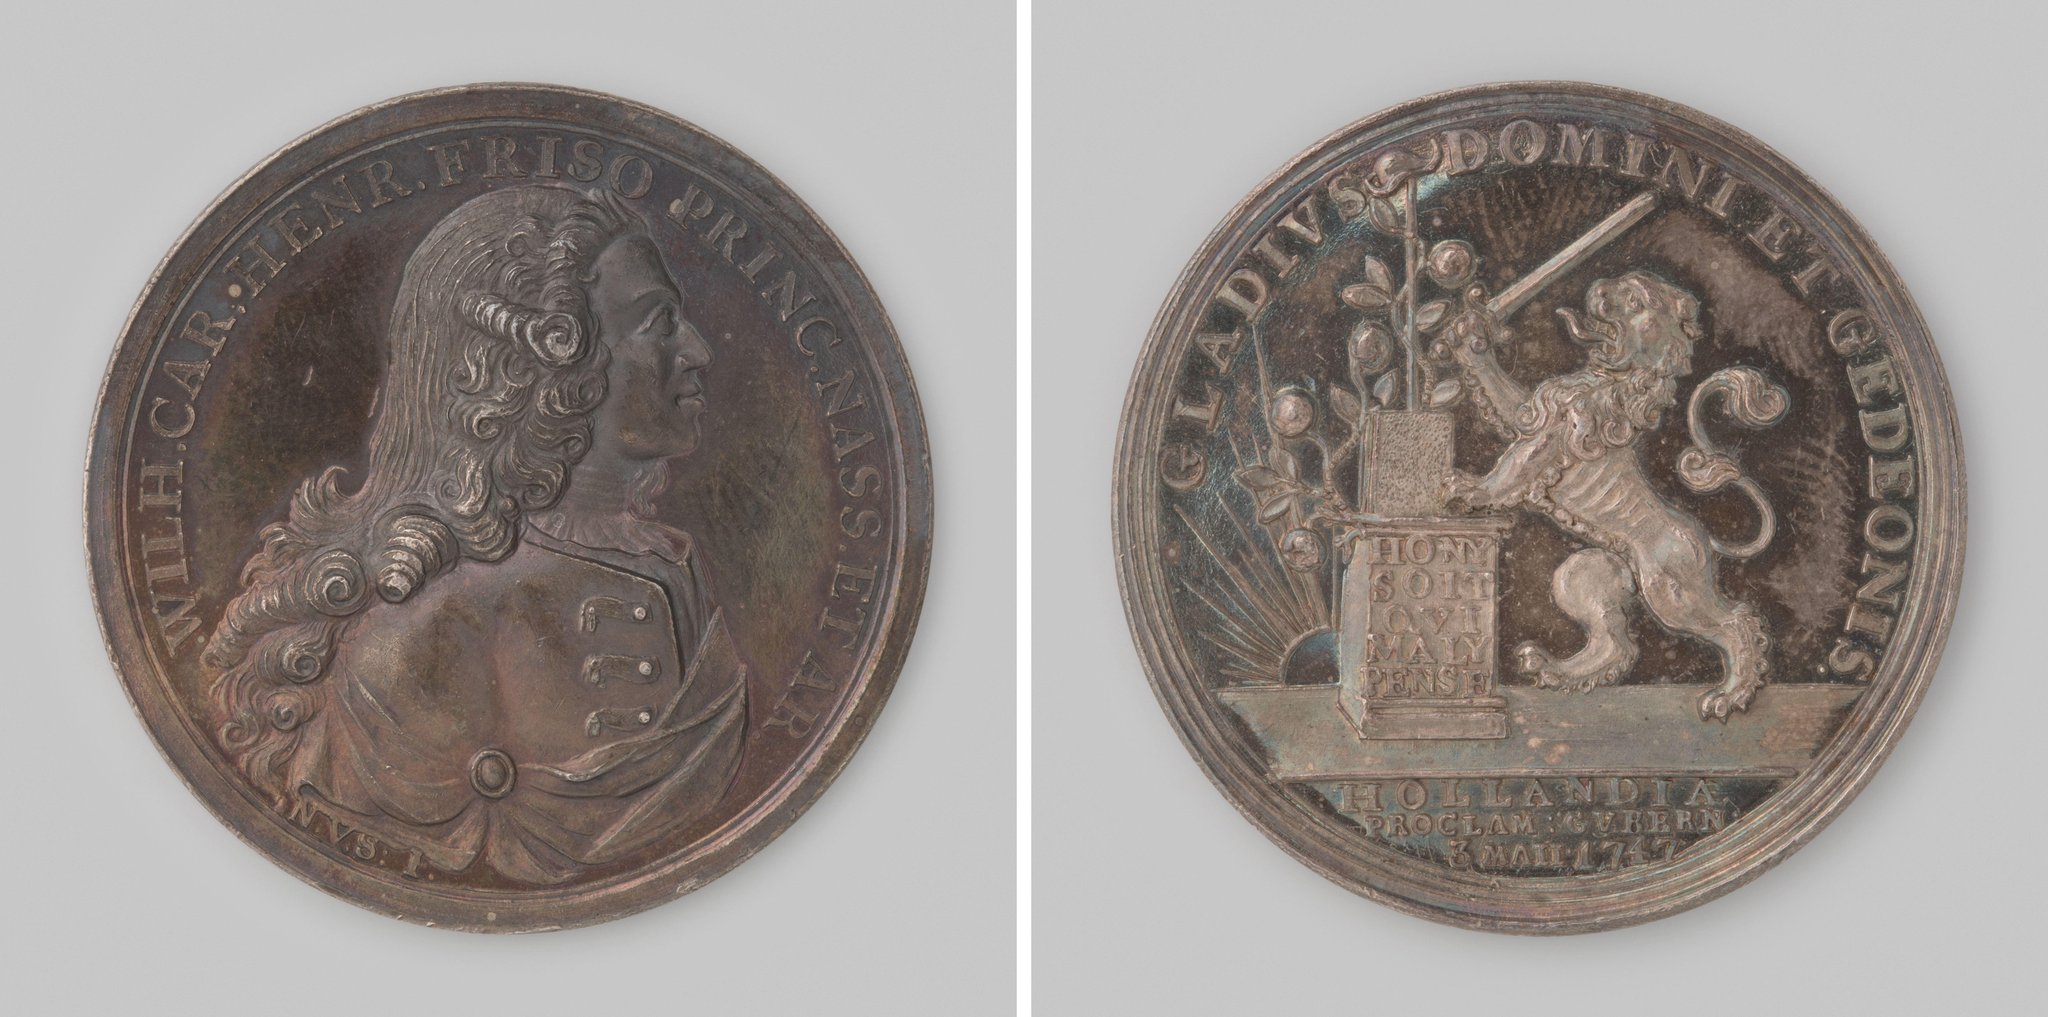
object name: history medal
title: Verkiezing van Willem Karel Hendrik Friso tot stadhouder Willem IV 1747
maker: nicolaas van swinderen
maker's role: jeweler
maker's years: 1705-1760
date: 1747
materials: silver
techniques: striking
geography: the hague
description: Zilveren penning, op de voorzijde het borstbeeld van Willem IV naar rechts met omschrift, op de keerzijde de Nederlandse leeuw met zwaard bij een beschreven altaar, met bijbel, piek met vrijheidshoed en oranjetakken, bij opgaande zon, met omschrift en afsnedetekst.